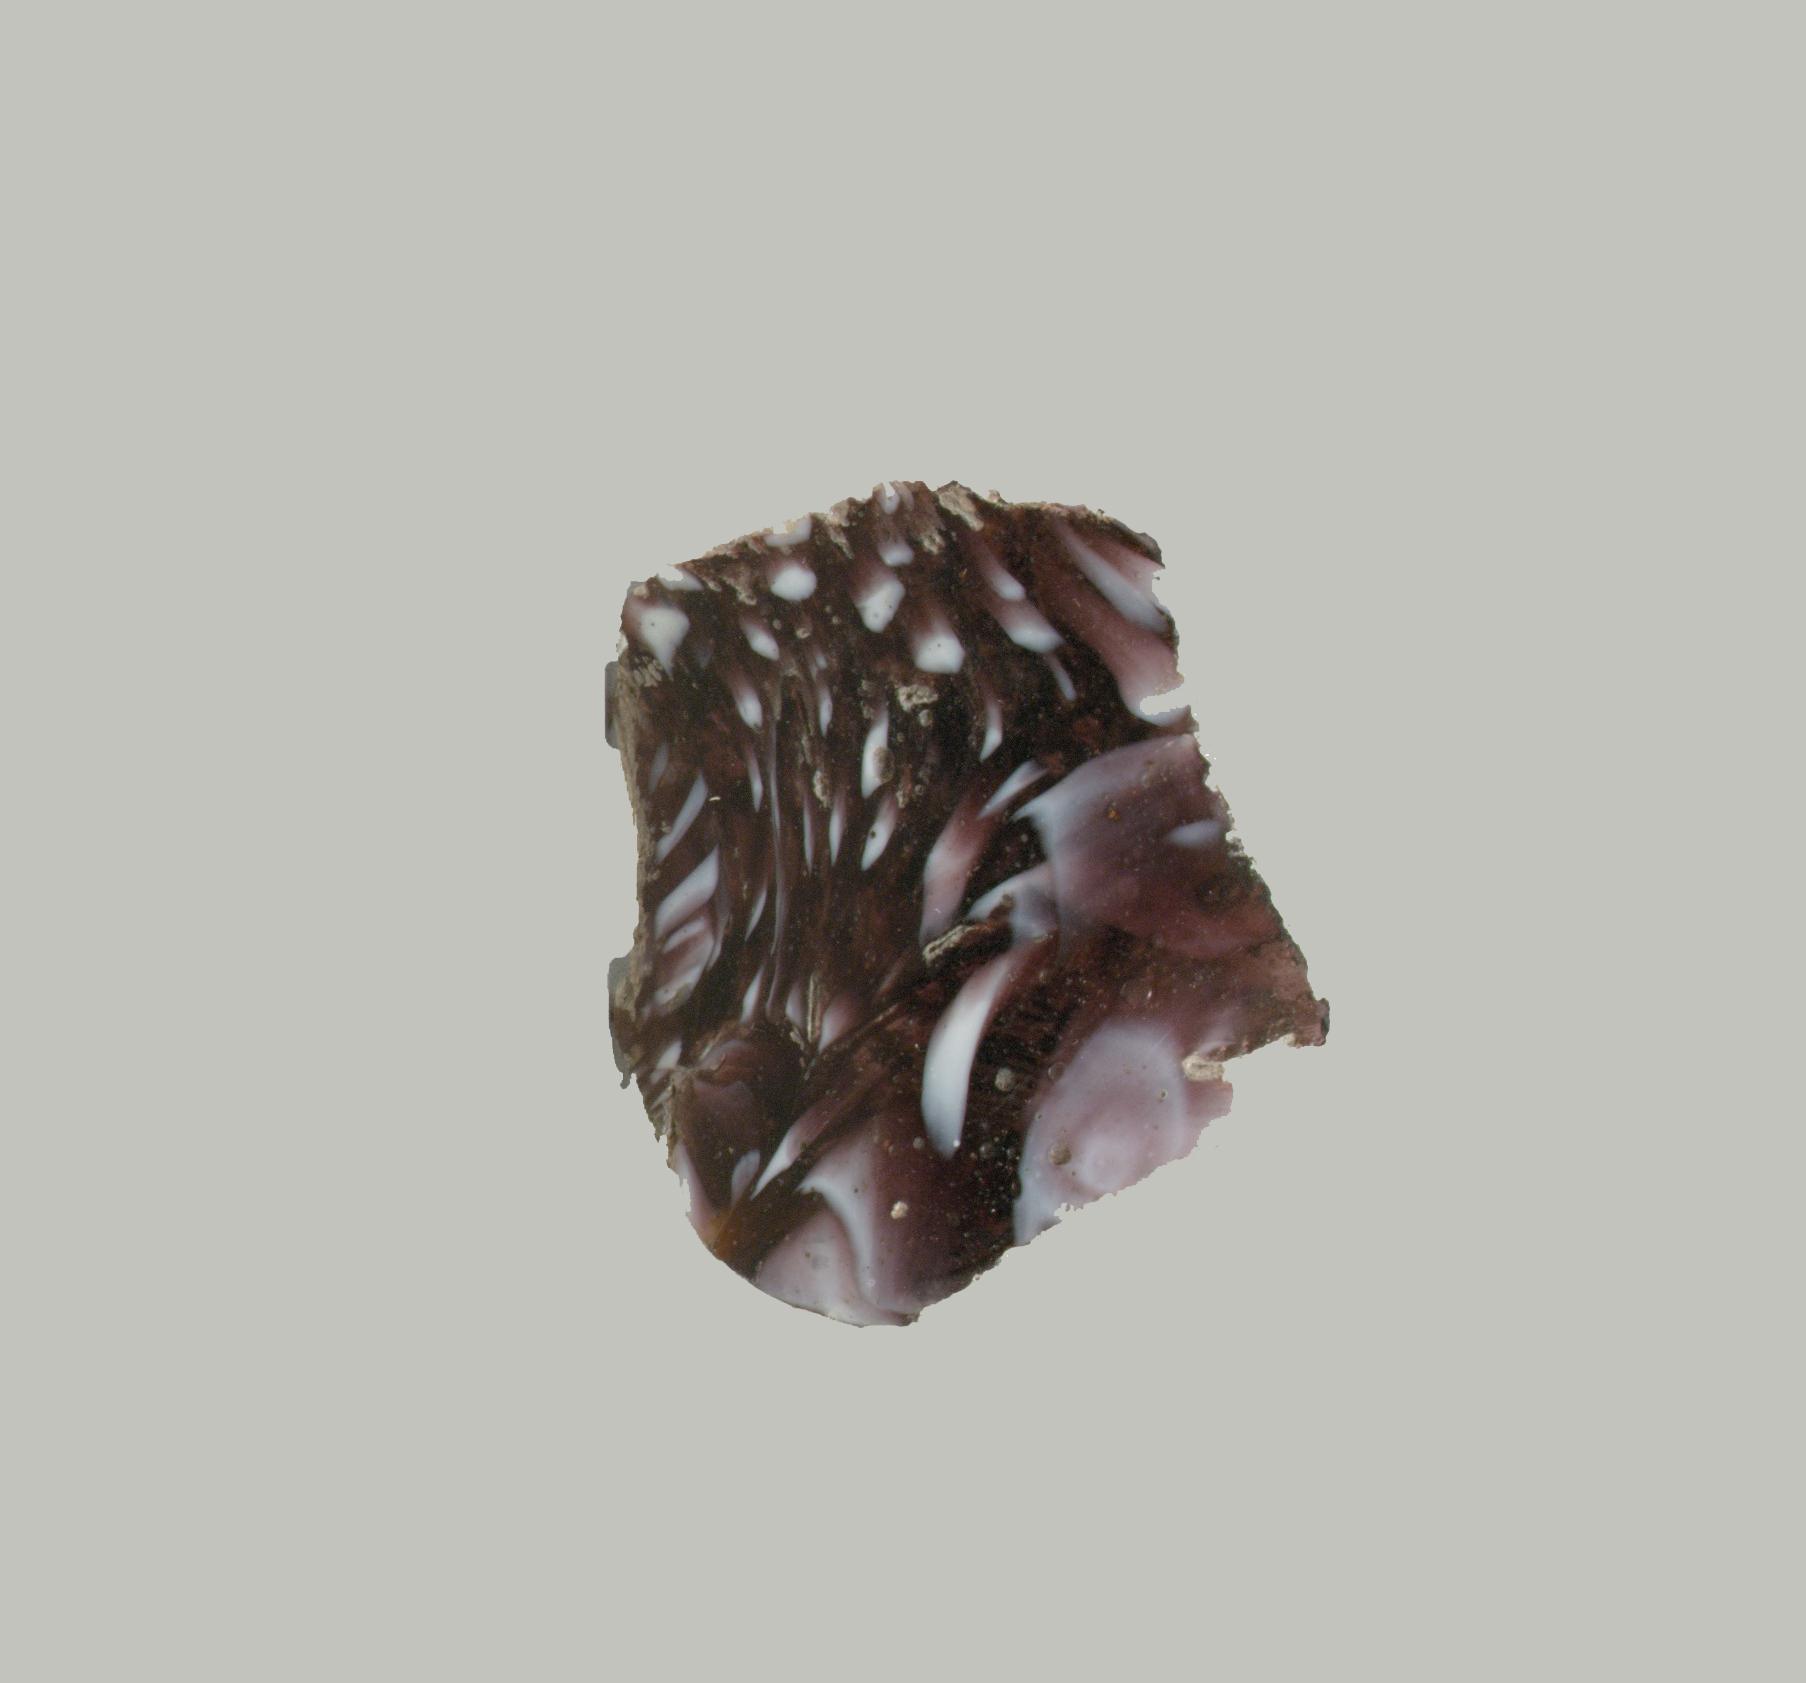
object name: fragment, mosaic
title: Glass mosaic bowl fragment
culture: roman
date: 34 BCE-33 CE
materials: glass